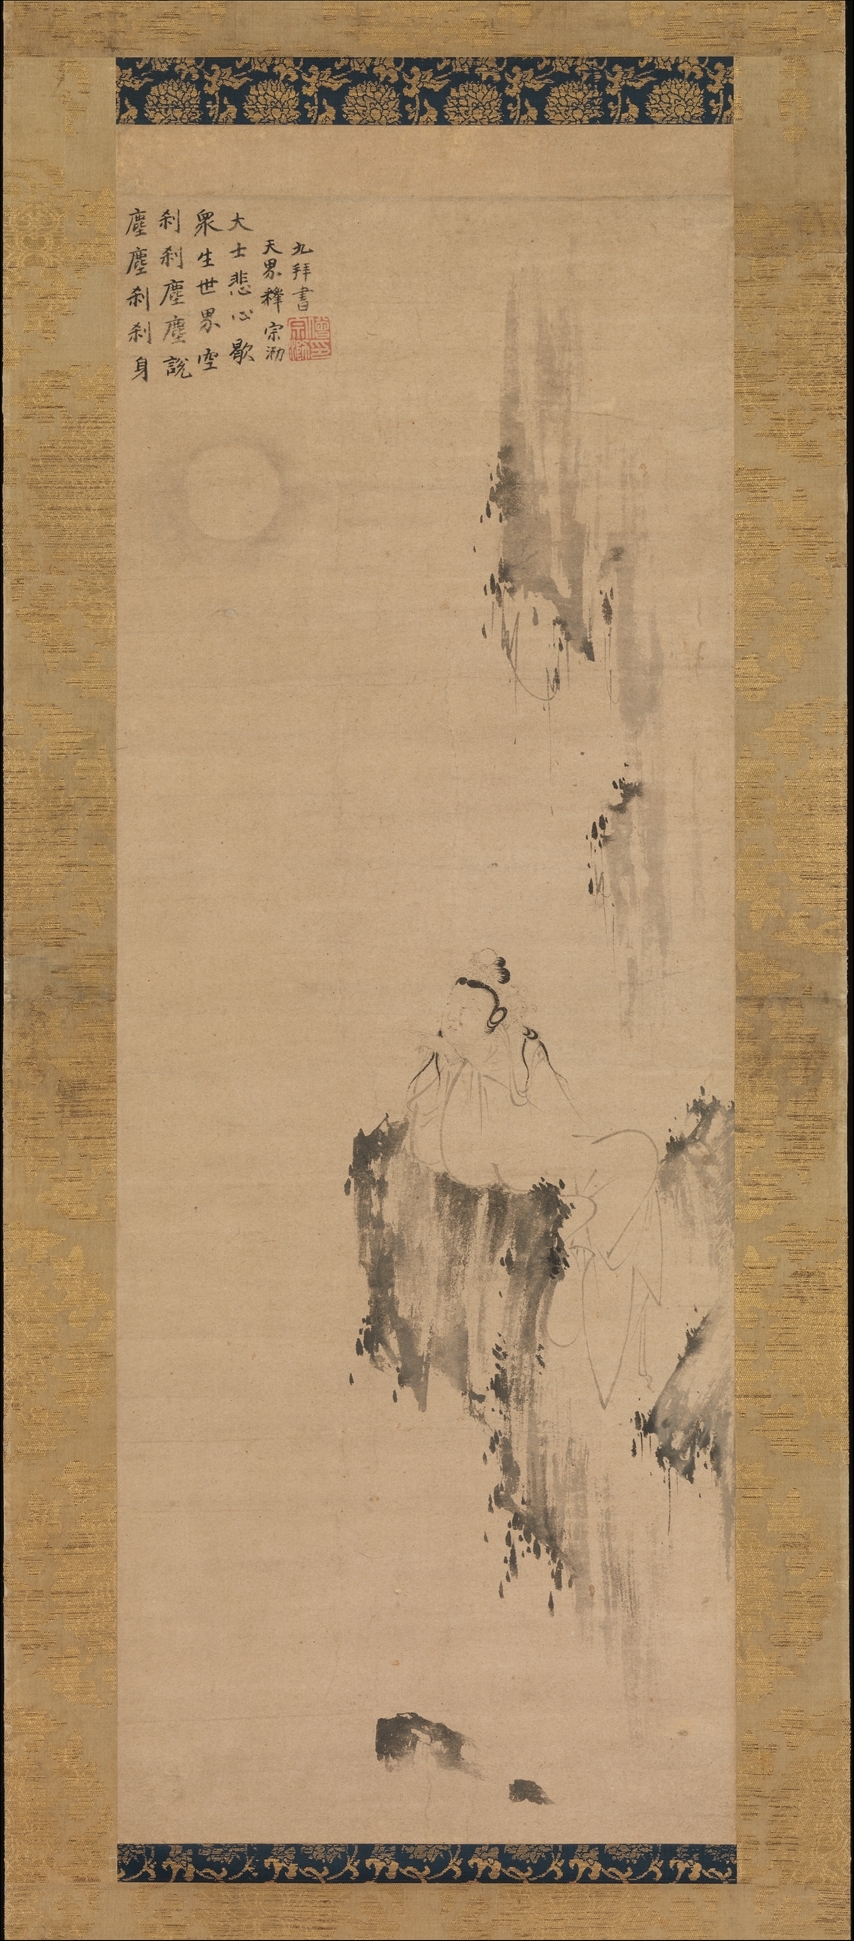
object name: hanging scroll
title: White-Robed Guanyin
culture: chinese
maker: unidentified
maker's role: artist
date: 1367-1400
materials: ink, paper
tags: buddhism,bodhisattvas